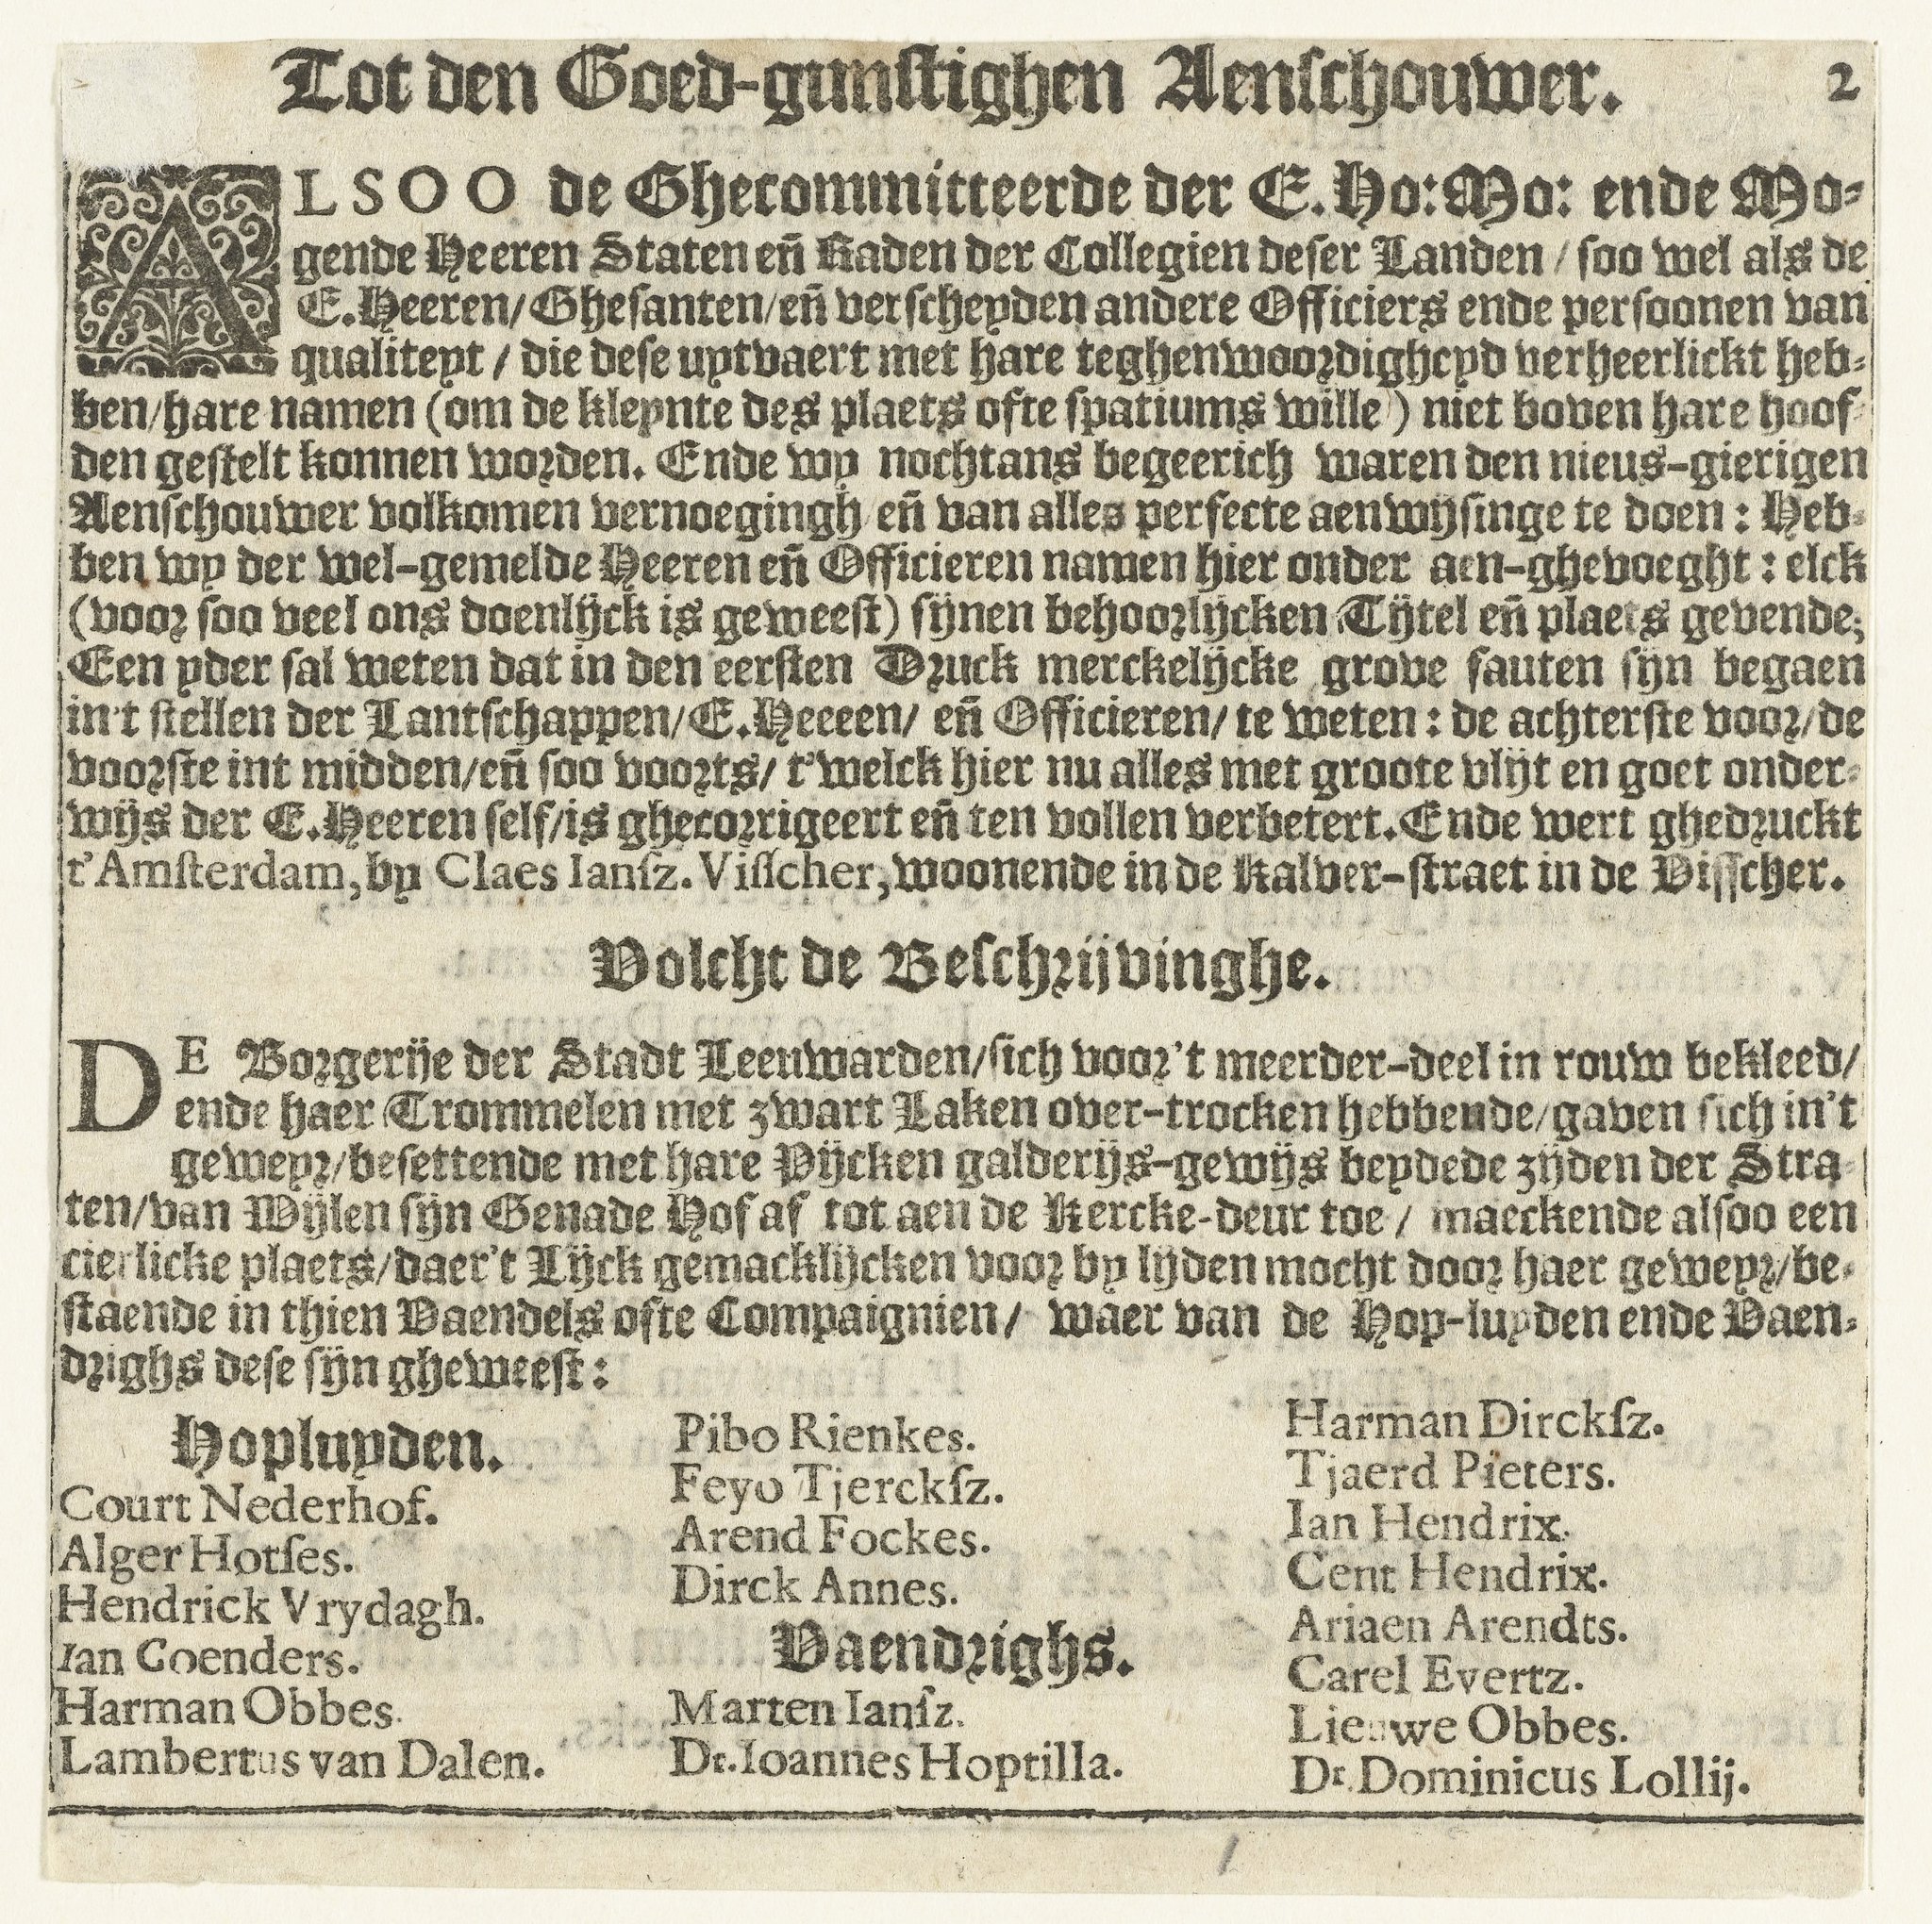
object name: text sheet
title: Tekstblad bij de begrafenis van Willem Lodewijk, graaf van Nassau, in de Grote Kerk te Leeuwarden, 1620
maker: claes jansz. visscher (ii)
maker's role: draughtsman, print maker, publisher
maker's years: 1586-1652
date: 1620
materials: paper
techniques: letterpress printing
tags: willem lodewijk graaf van nassau-dillenburg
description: Uit de aanhef aan de aanschouwer is af te leiden dat het hier gaat om een herziene uitgave van de oorspronkelijke teksten, die bij de prent behoren, met een verbetering van de fouten en omissies. Voor de prenten zie de nrs RP-P-OB-76.414 t/m 76.417.